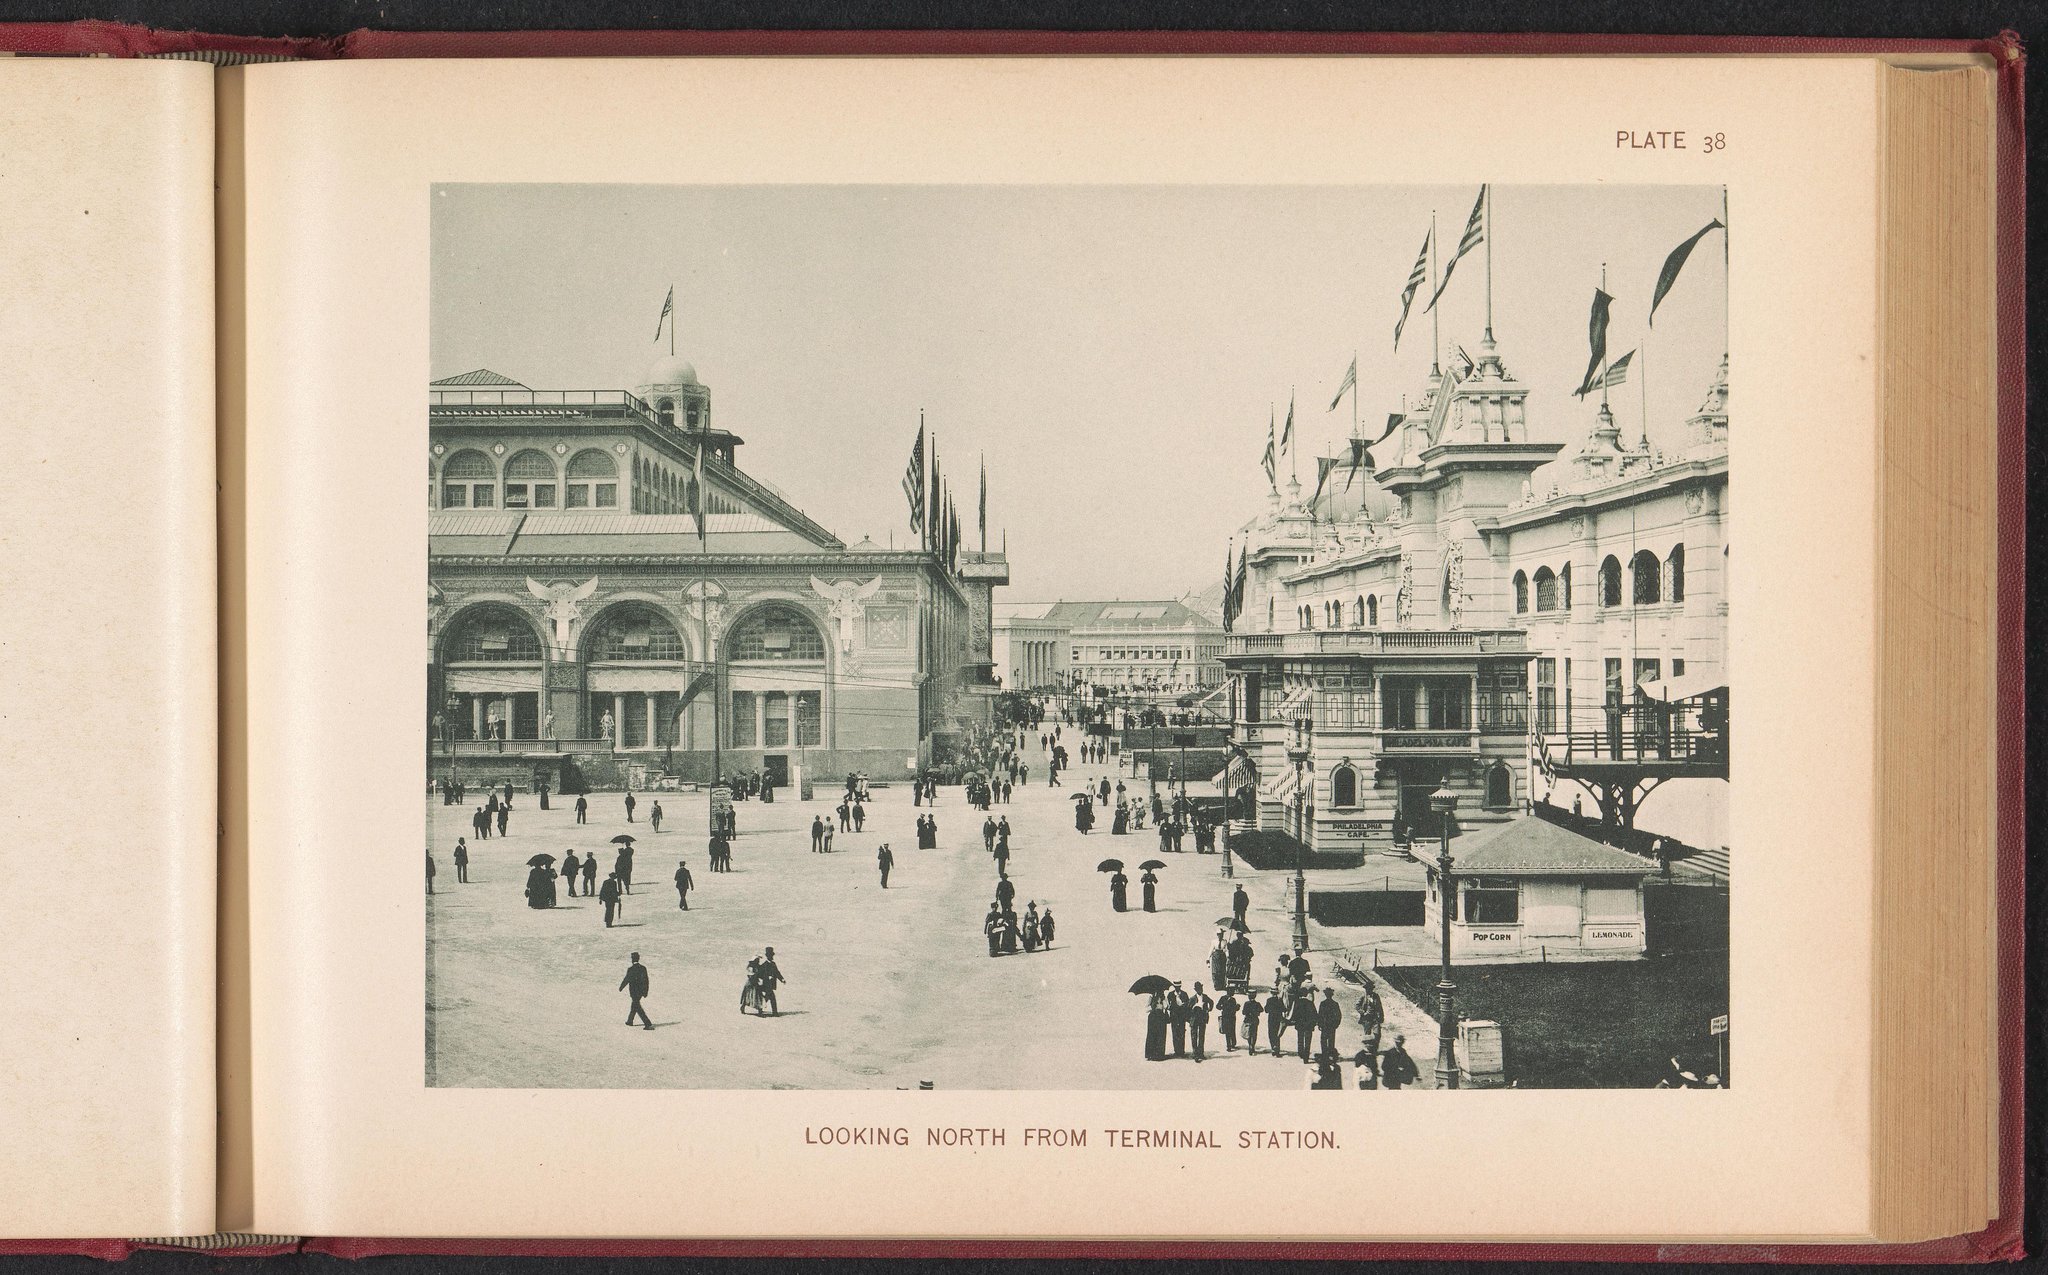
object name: photomechanical print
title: Gezicht op de World's Columbian Exposition in Chicago in 1893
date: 1893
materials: paper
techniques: photograph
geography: chicago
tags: world fair, world exhibition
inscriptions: number: ‘Plate 38’